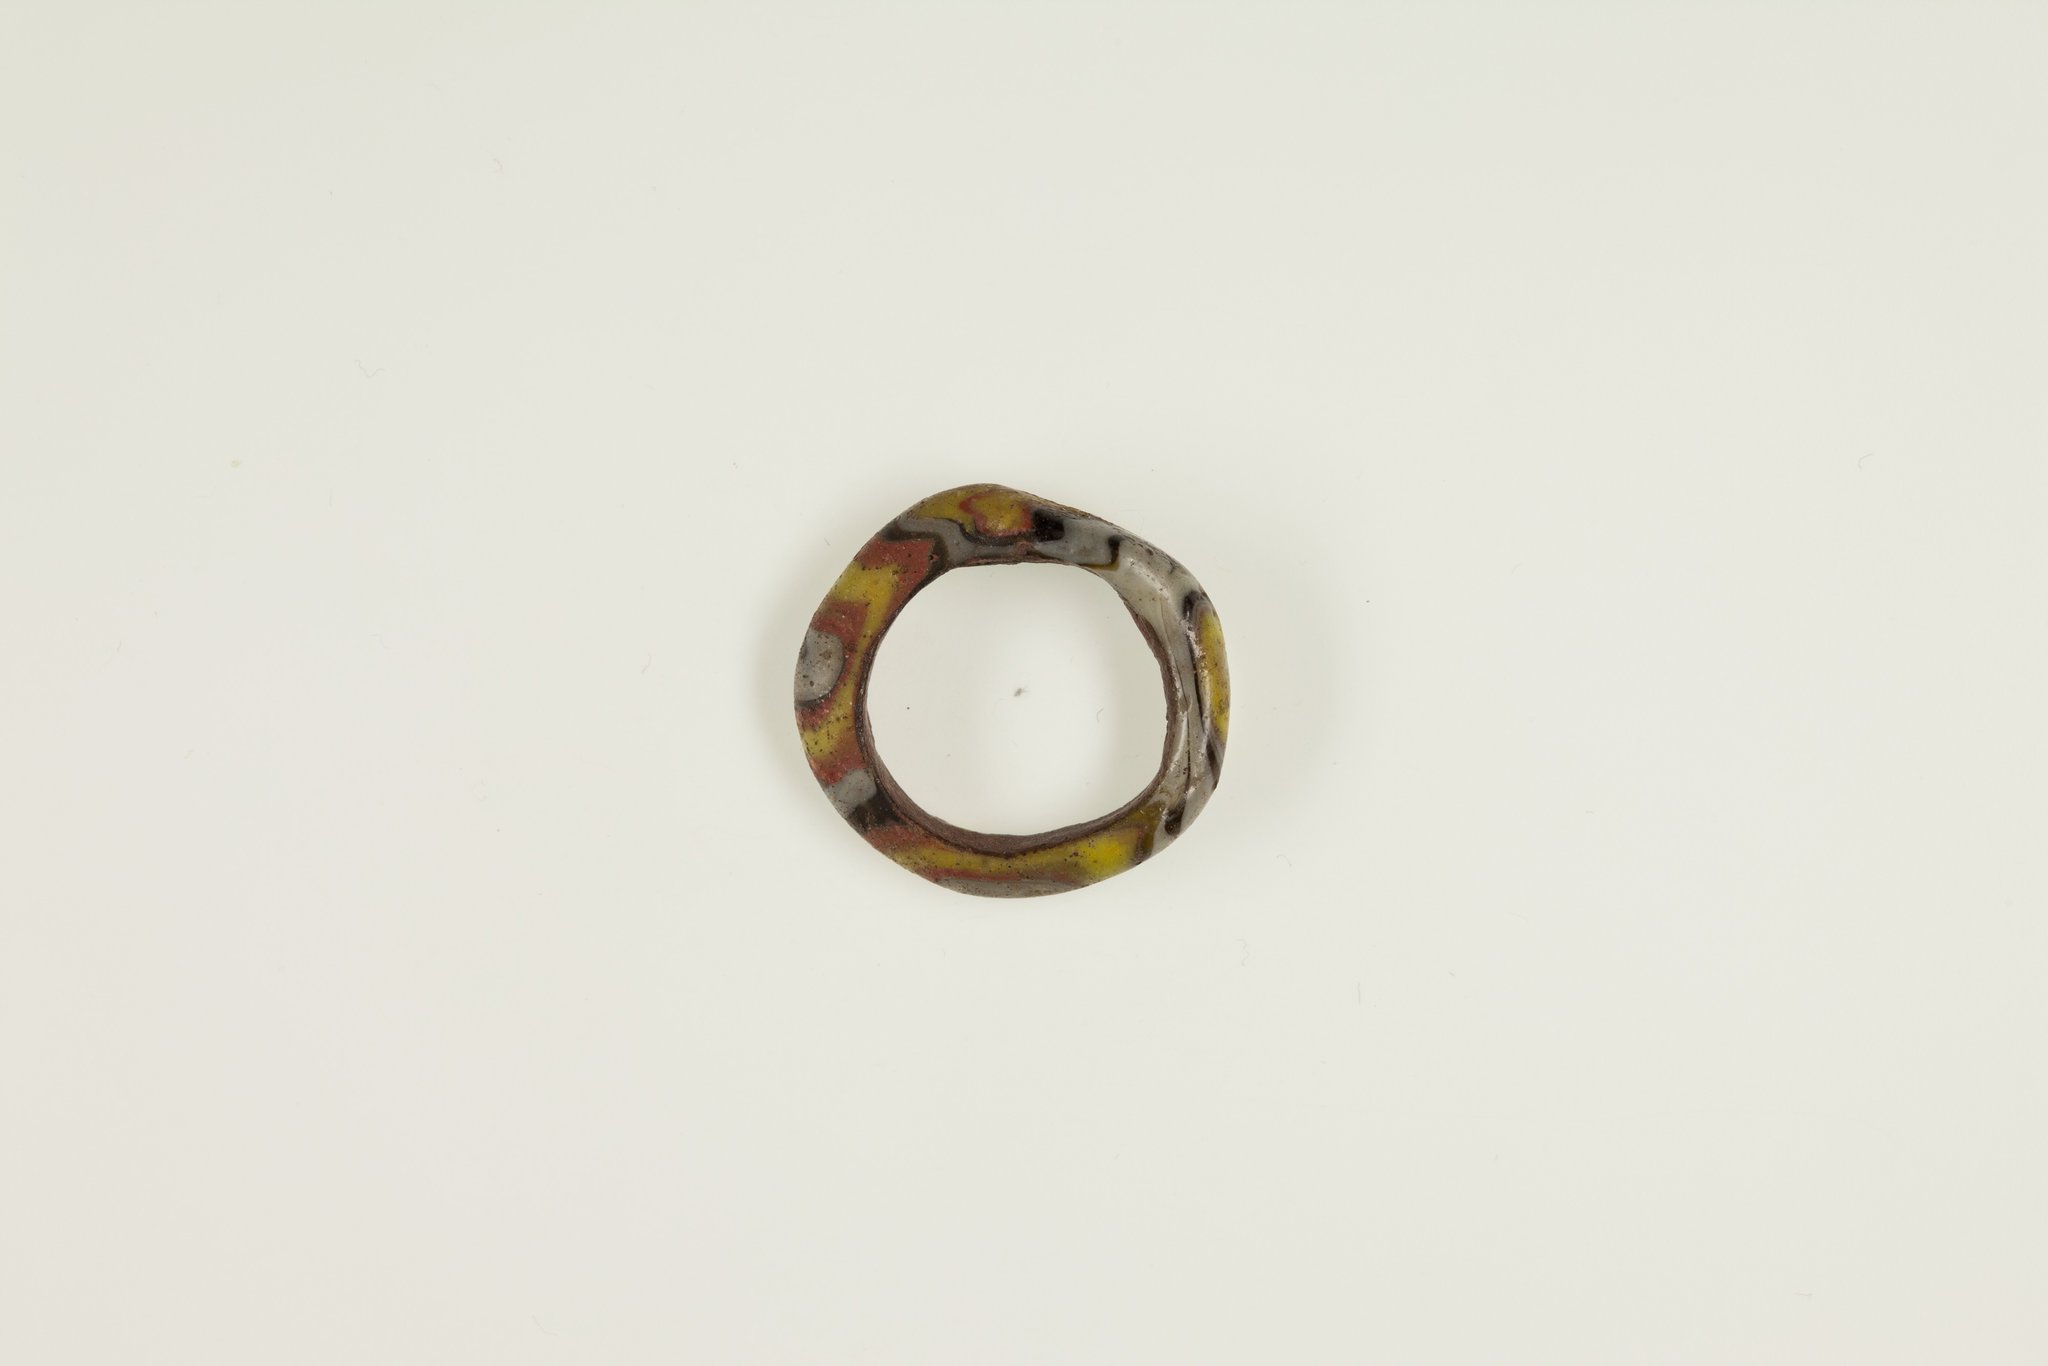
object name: ring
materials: glass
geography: egypt